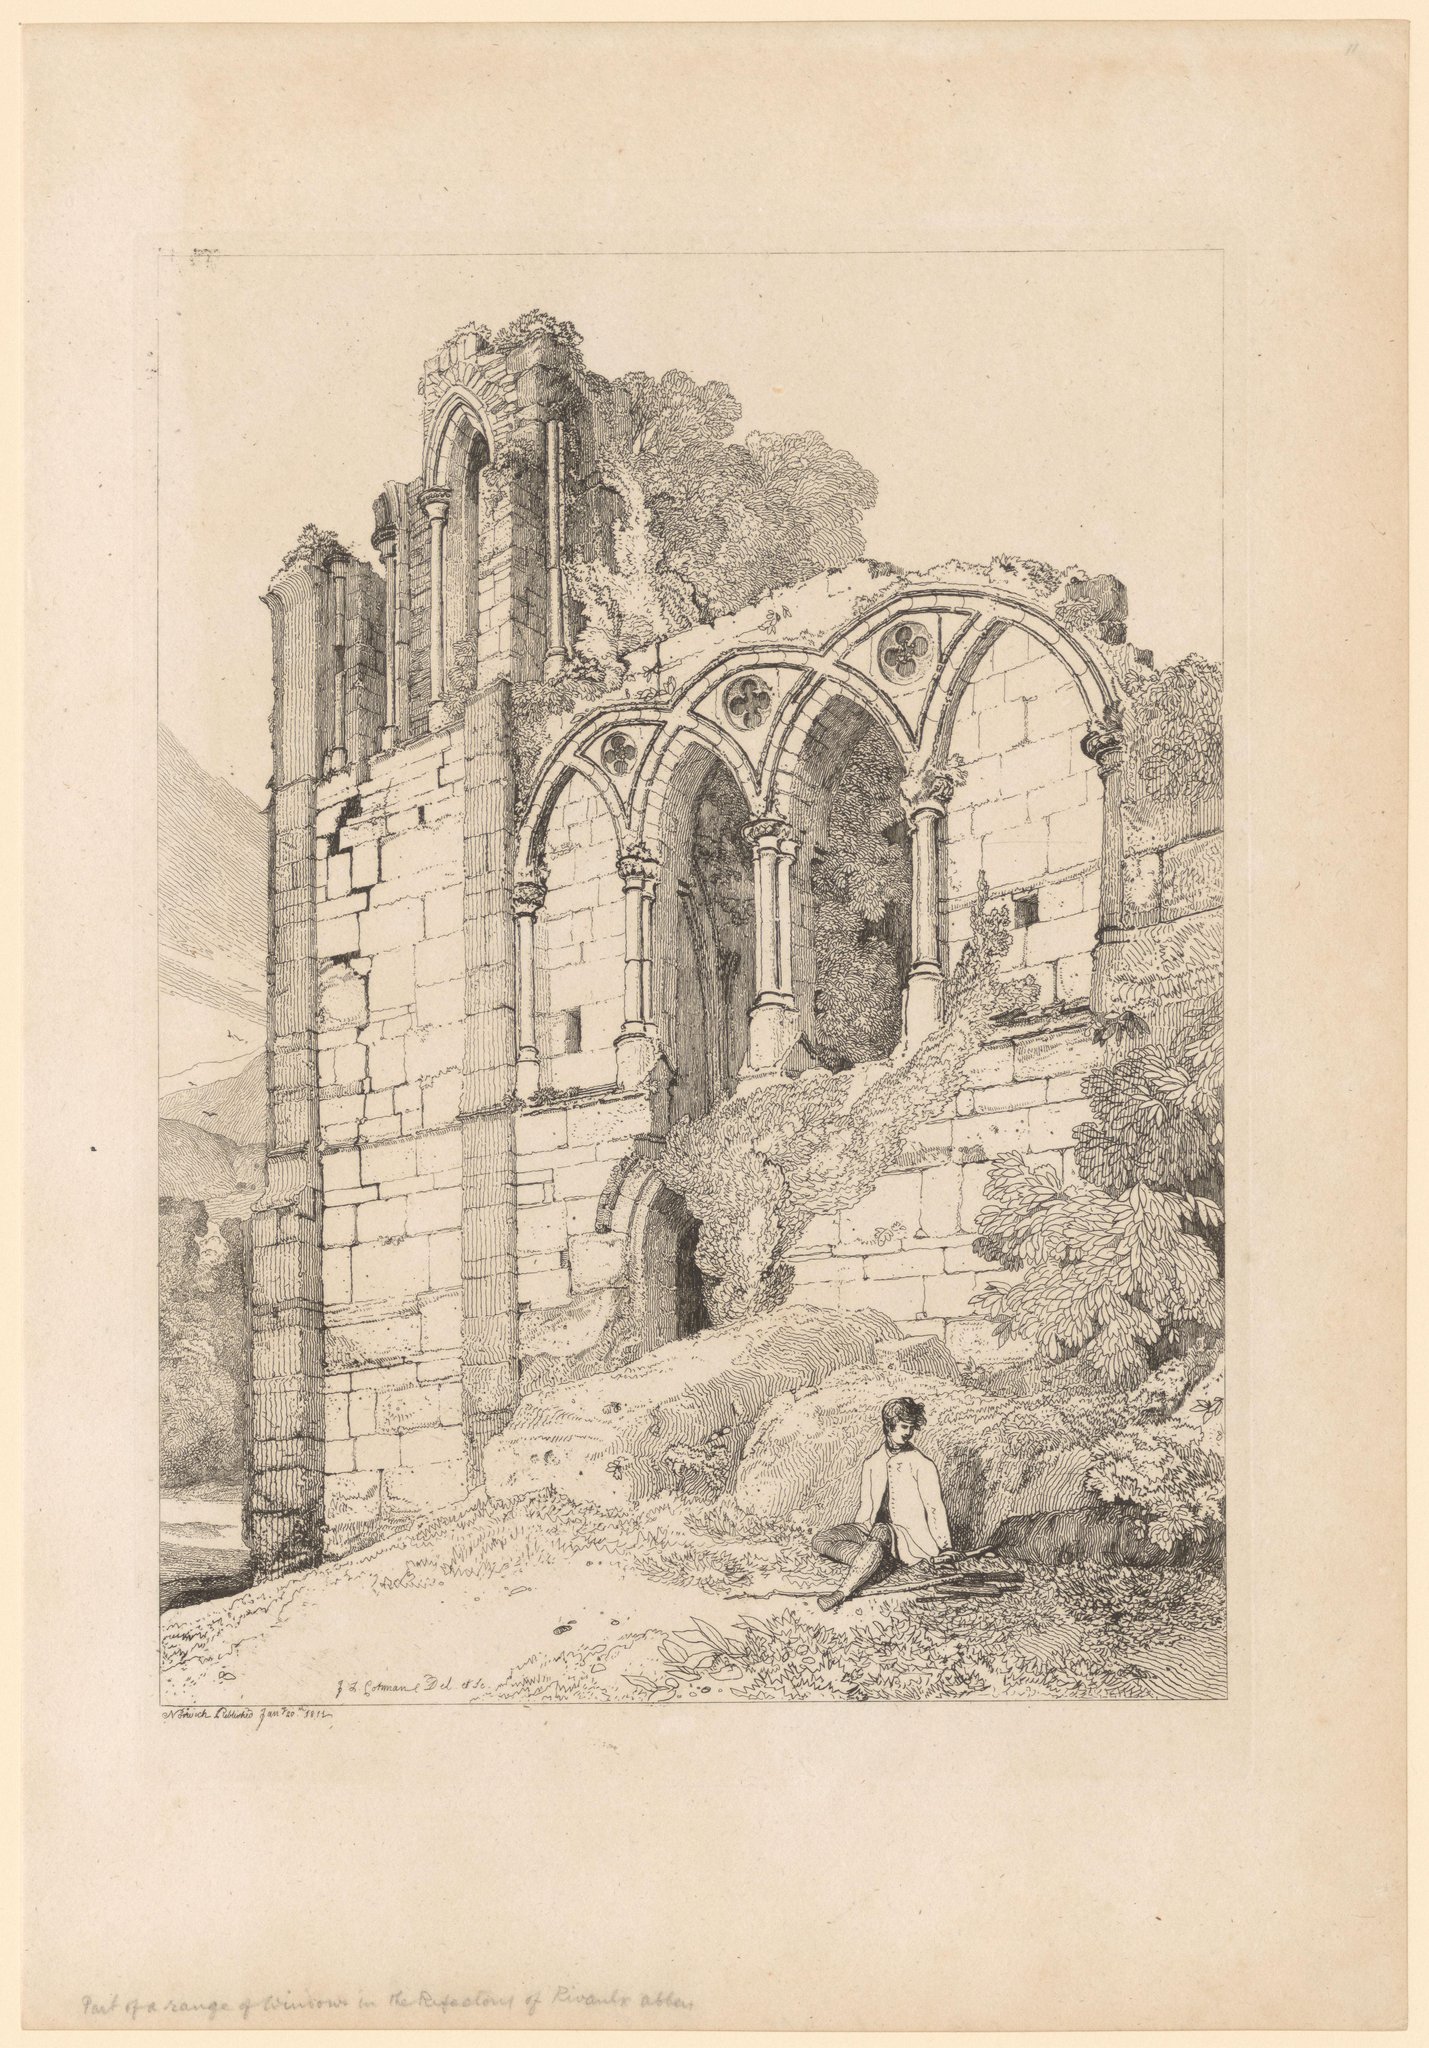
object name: print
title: Etchings by John Sell Cotman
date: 1801-1811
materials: paper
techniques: etching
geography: london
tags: window, ruin of church, monastery, etc., resting - bb - out of doors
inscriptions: collector's mark: Lugt 2760, collector's mark: Lugt 2228